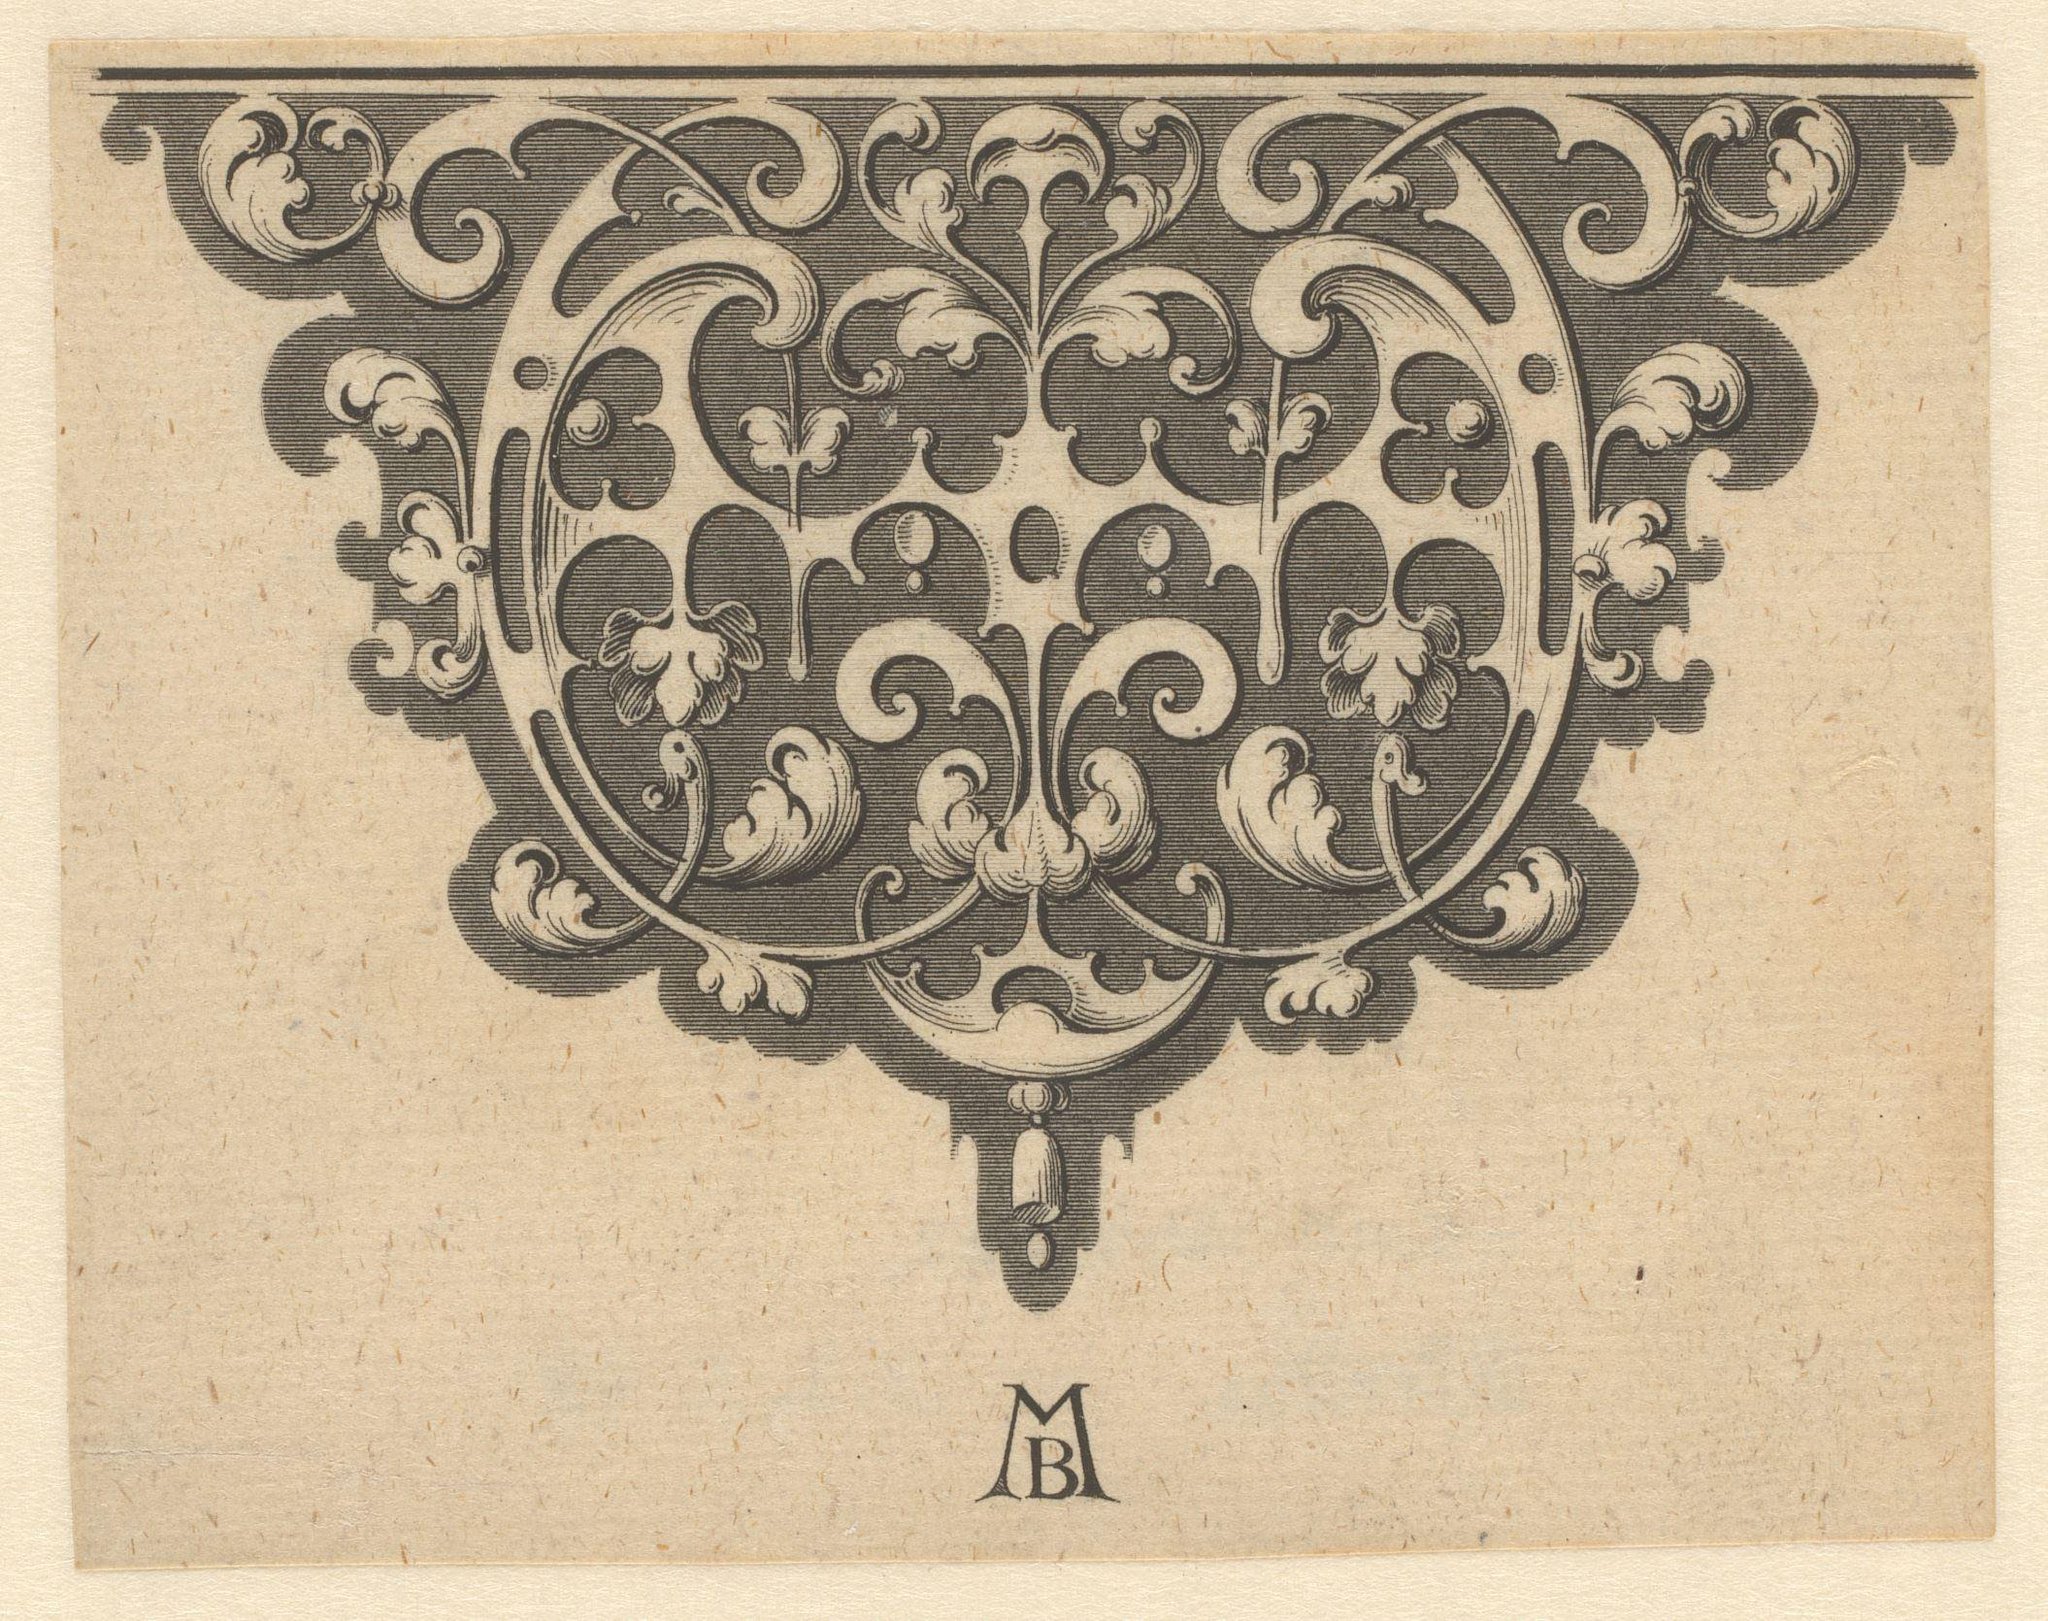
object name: print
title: Spits met bladwerk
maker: michiel le blon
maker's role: print maker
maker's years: 1587-1656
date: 1597-1656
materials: paper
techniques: engraving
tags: ornaments ~ art, foliage ~ ornament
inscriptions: collector's mark: Lugt 2760, monogram: ‘MB (M boven B)’, collector's mark: Lugt 2228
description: Ontwerp voor decoratie voor zilveren beker.